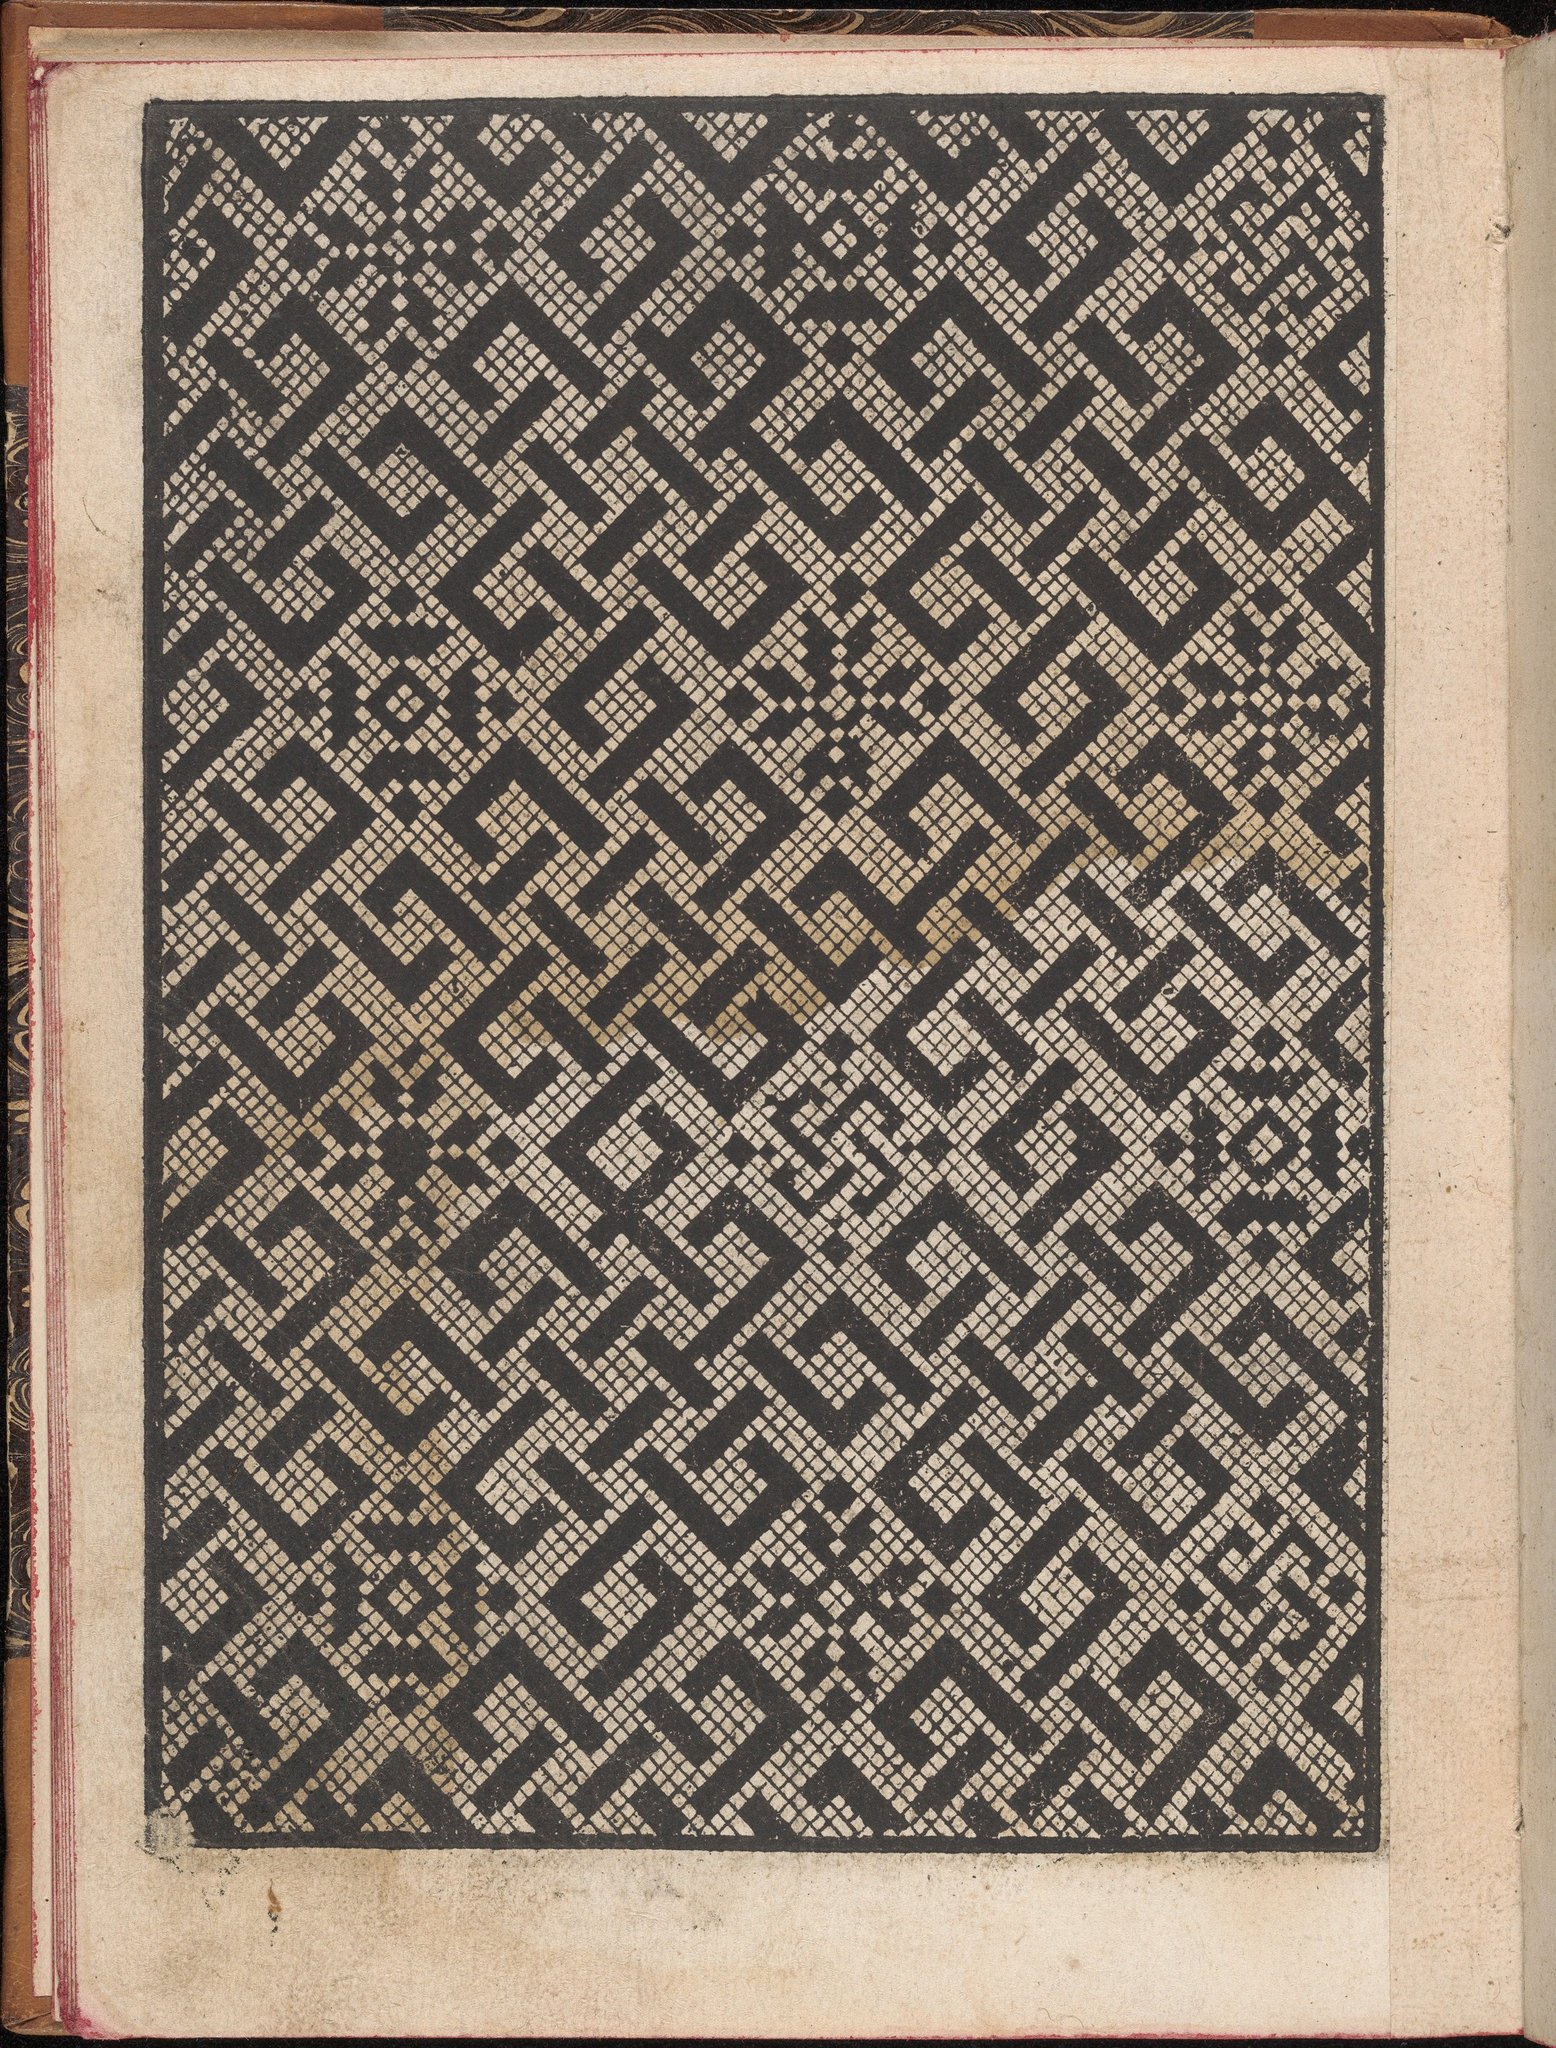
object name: book print ornament architecture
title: Spechio di pensieri delle belle et Virtudiose donne, page 6 (verso)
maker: matteo pagano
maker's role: publisher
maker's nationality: italian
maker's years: 1515-1588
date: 1546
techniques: woodcut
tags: ornament